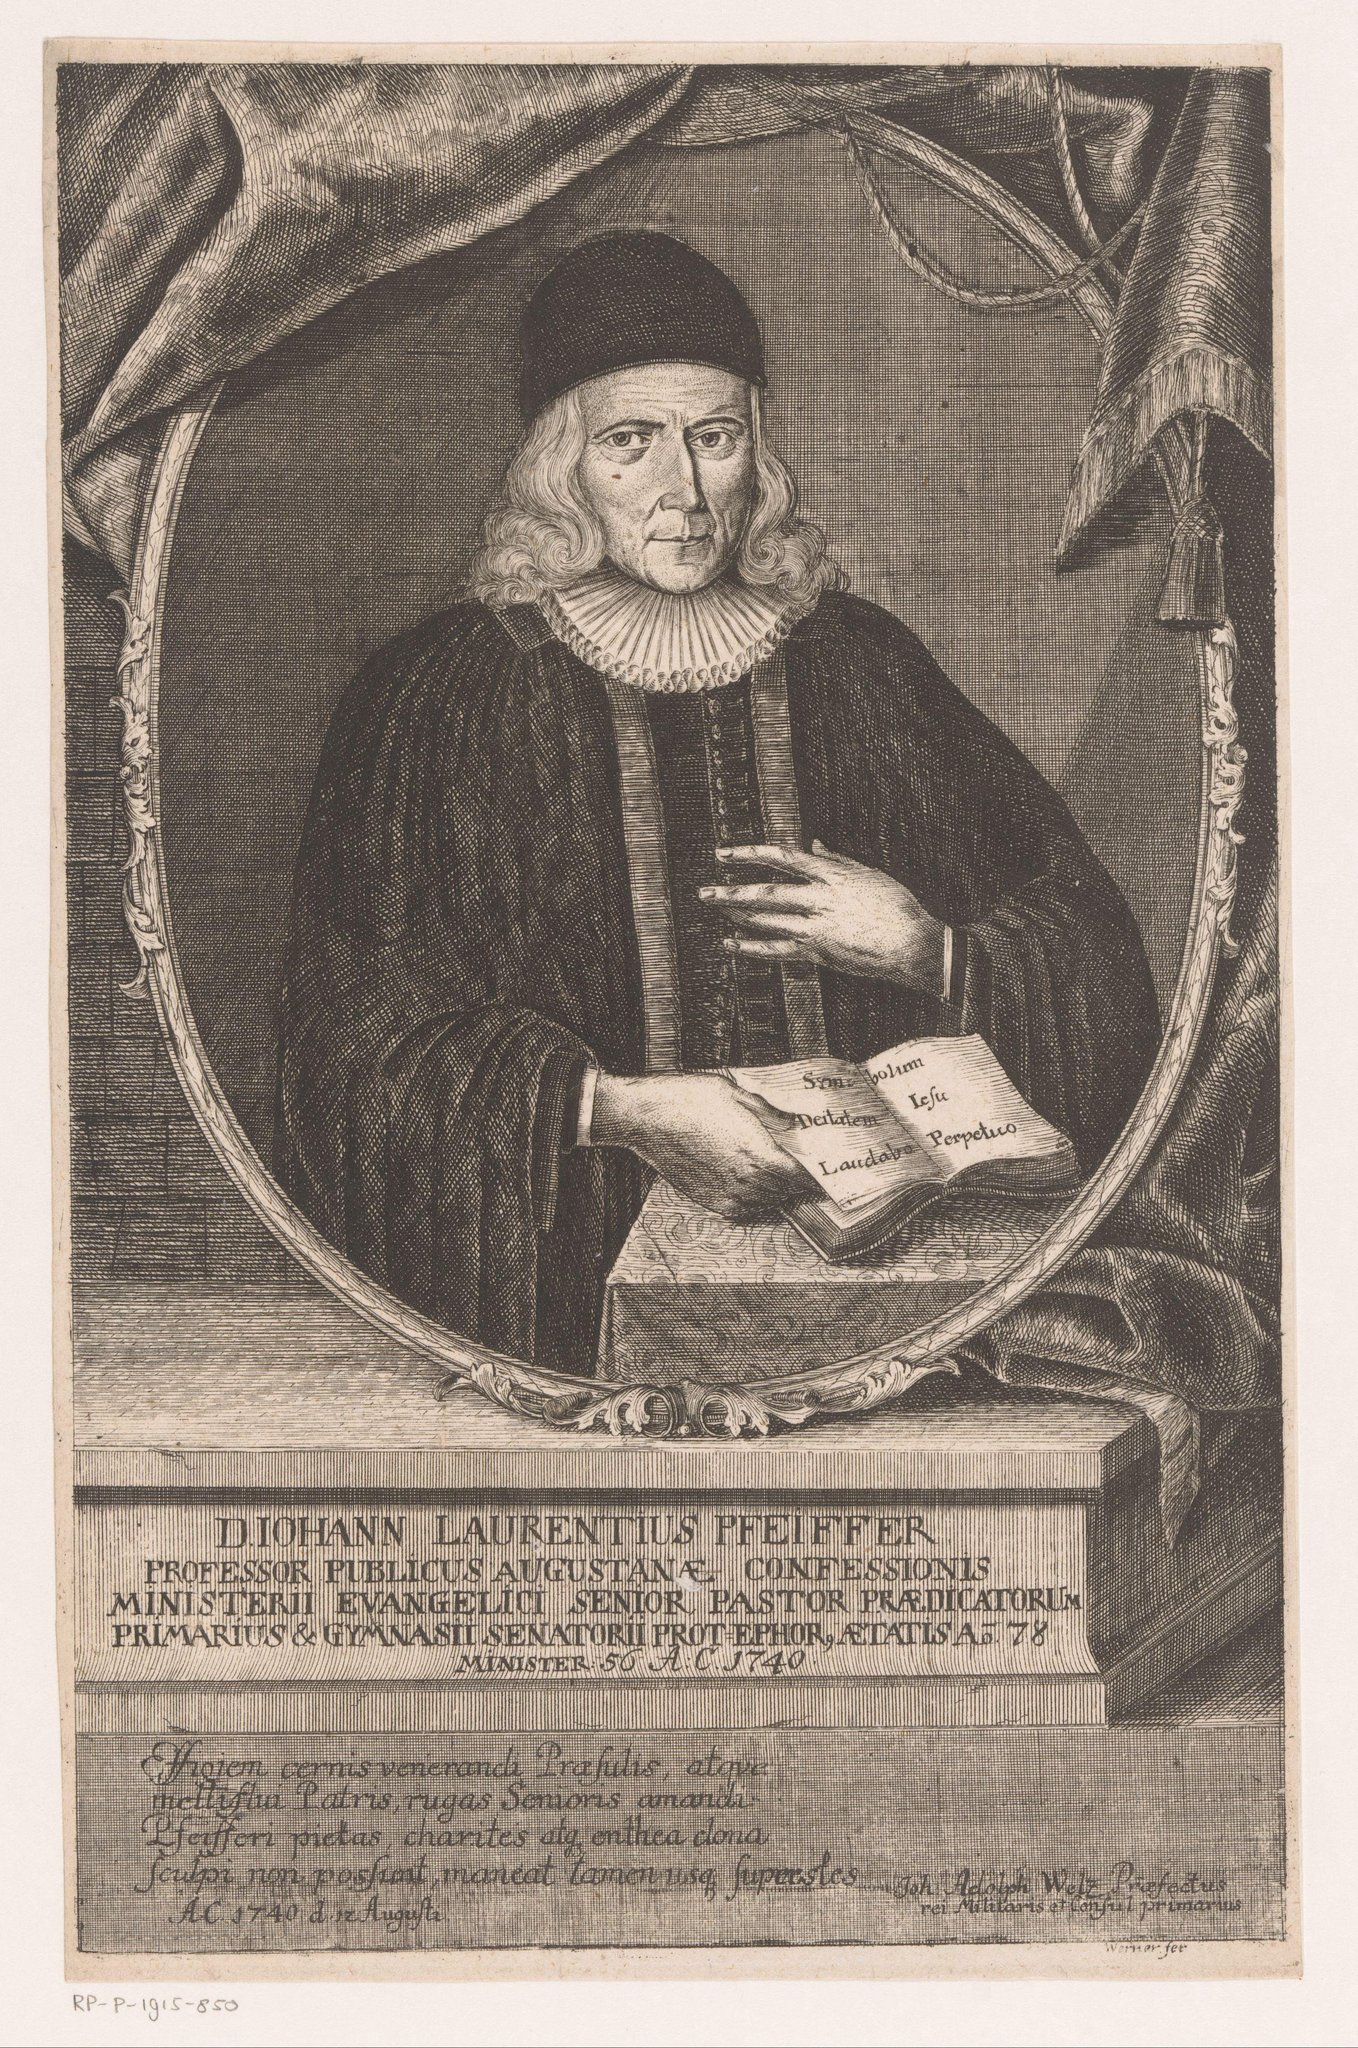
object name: print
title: Portret van Johann Lorenz Pfeiffer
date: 1740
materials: paper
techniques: engraving, etching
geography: germany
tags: historical persons, book - mm - book open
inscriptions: collector's mark: Lugt 2228